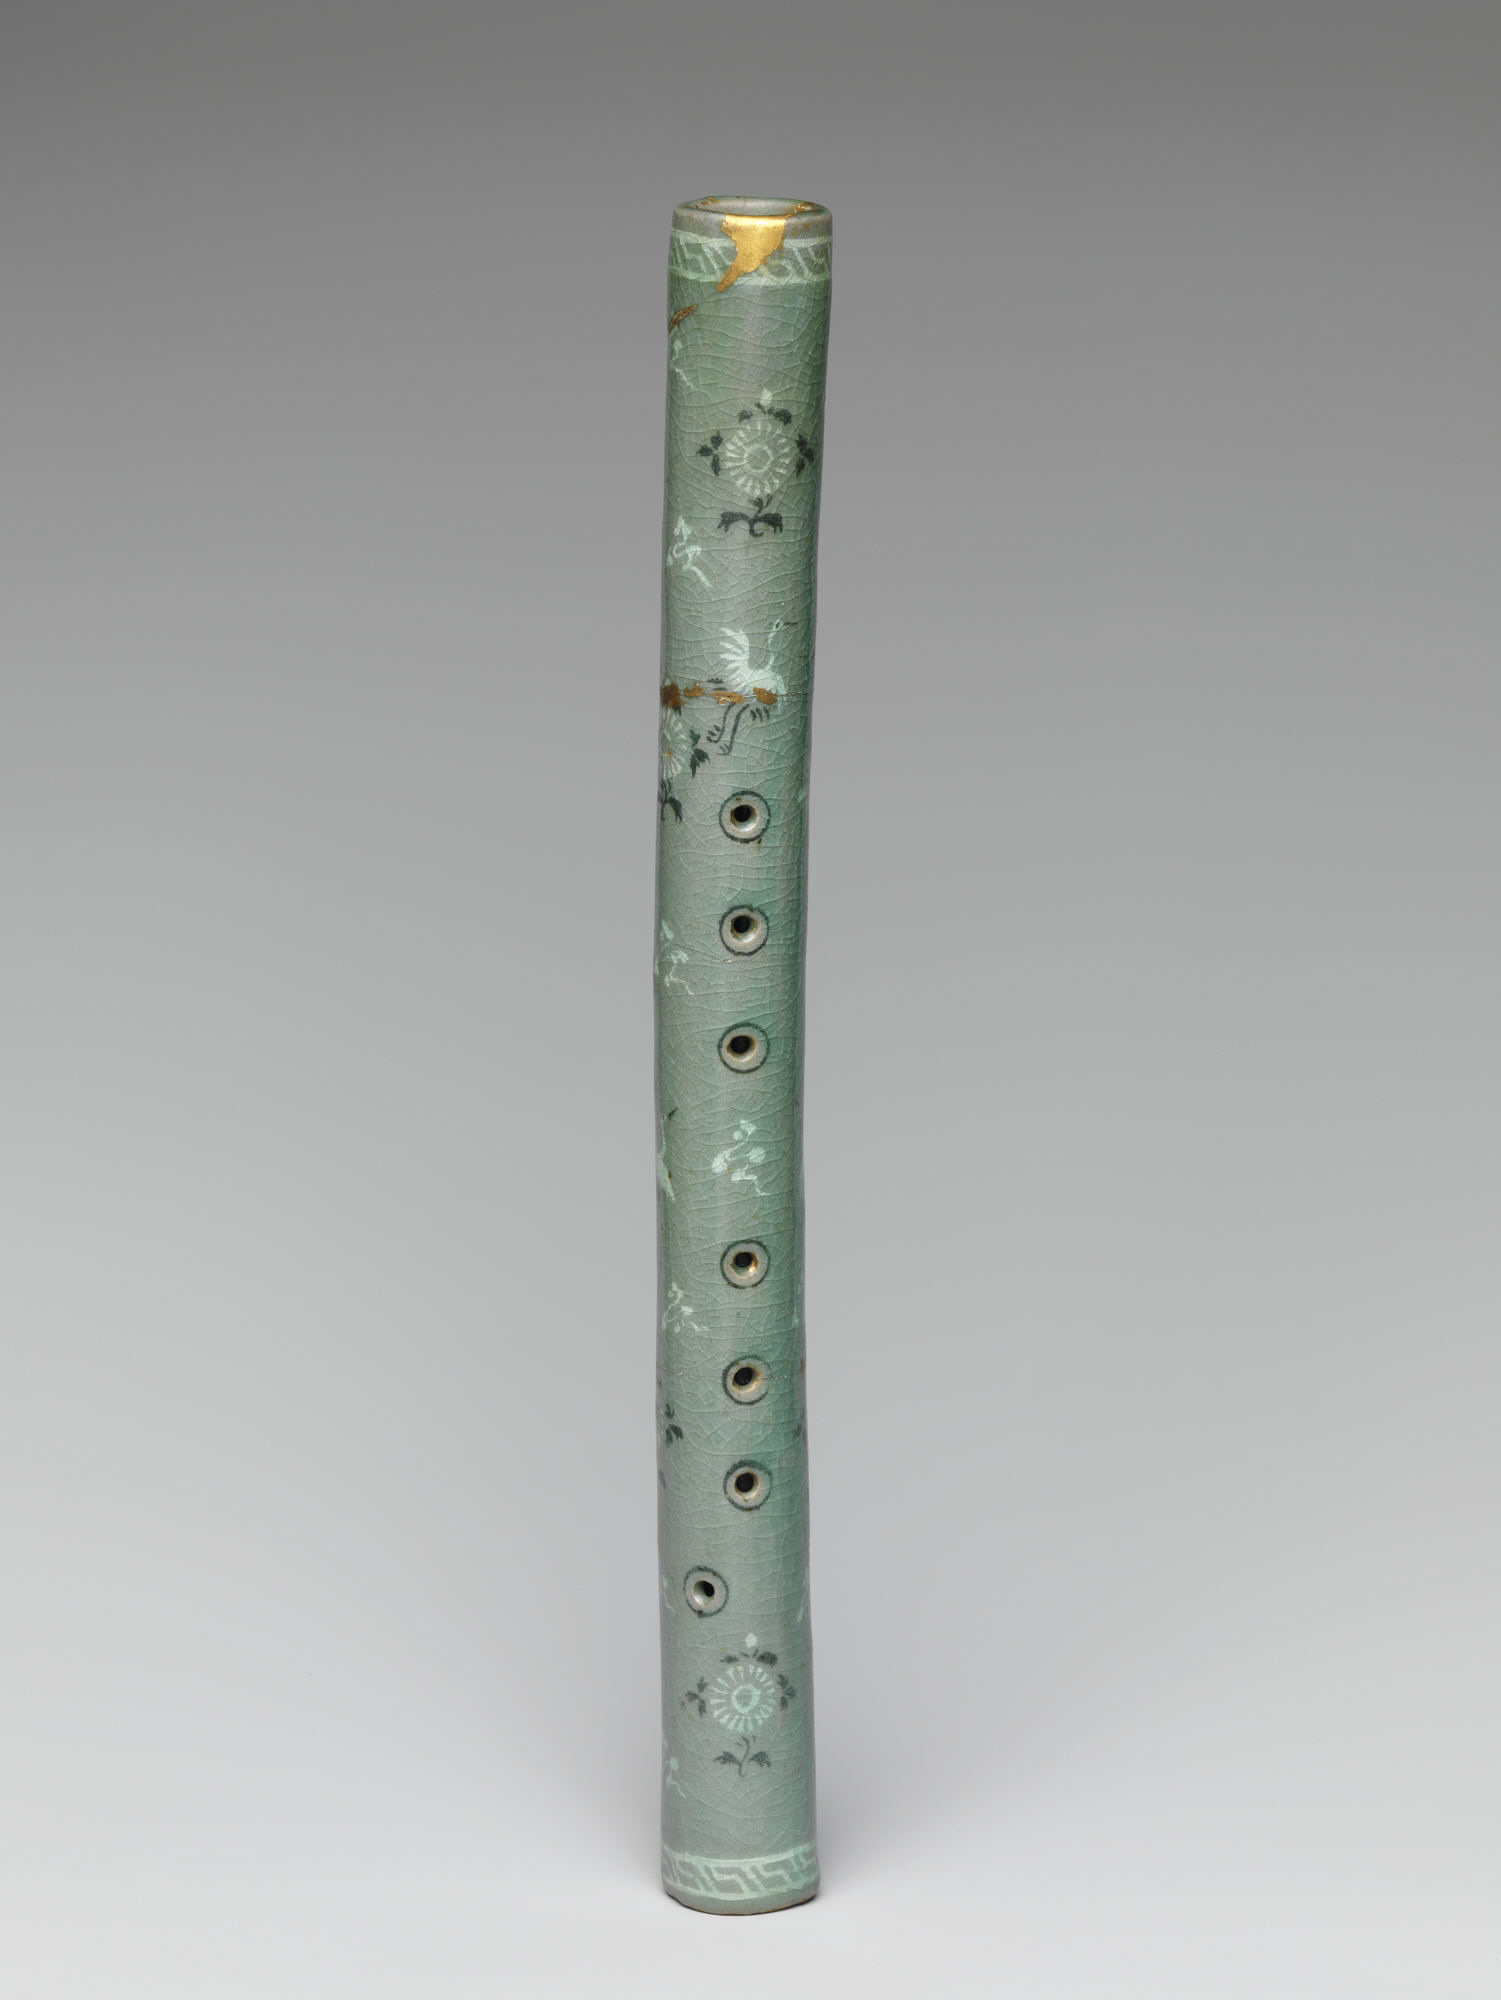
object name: flute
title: Vertical flute decorated with chrysanthemums, cranes, and clouds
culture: korean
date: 1201-1233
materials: ceramic glaze, glaze, stoneware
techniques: inlay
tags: cranes,flutes,flowers